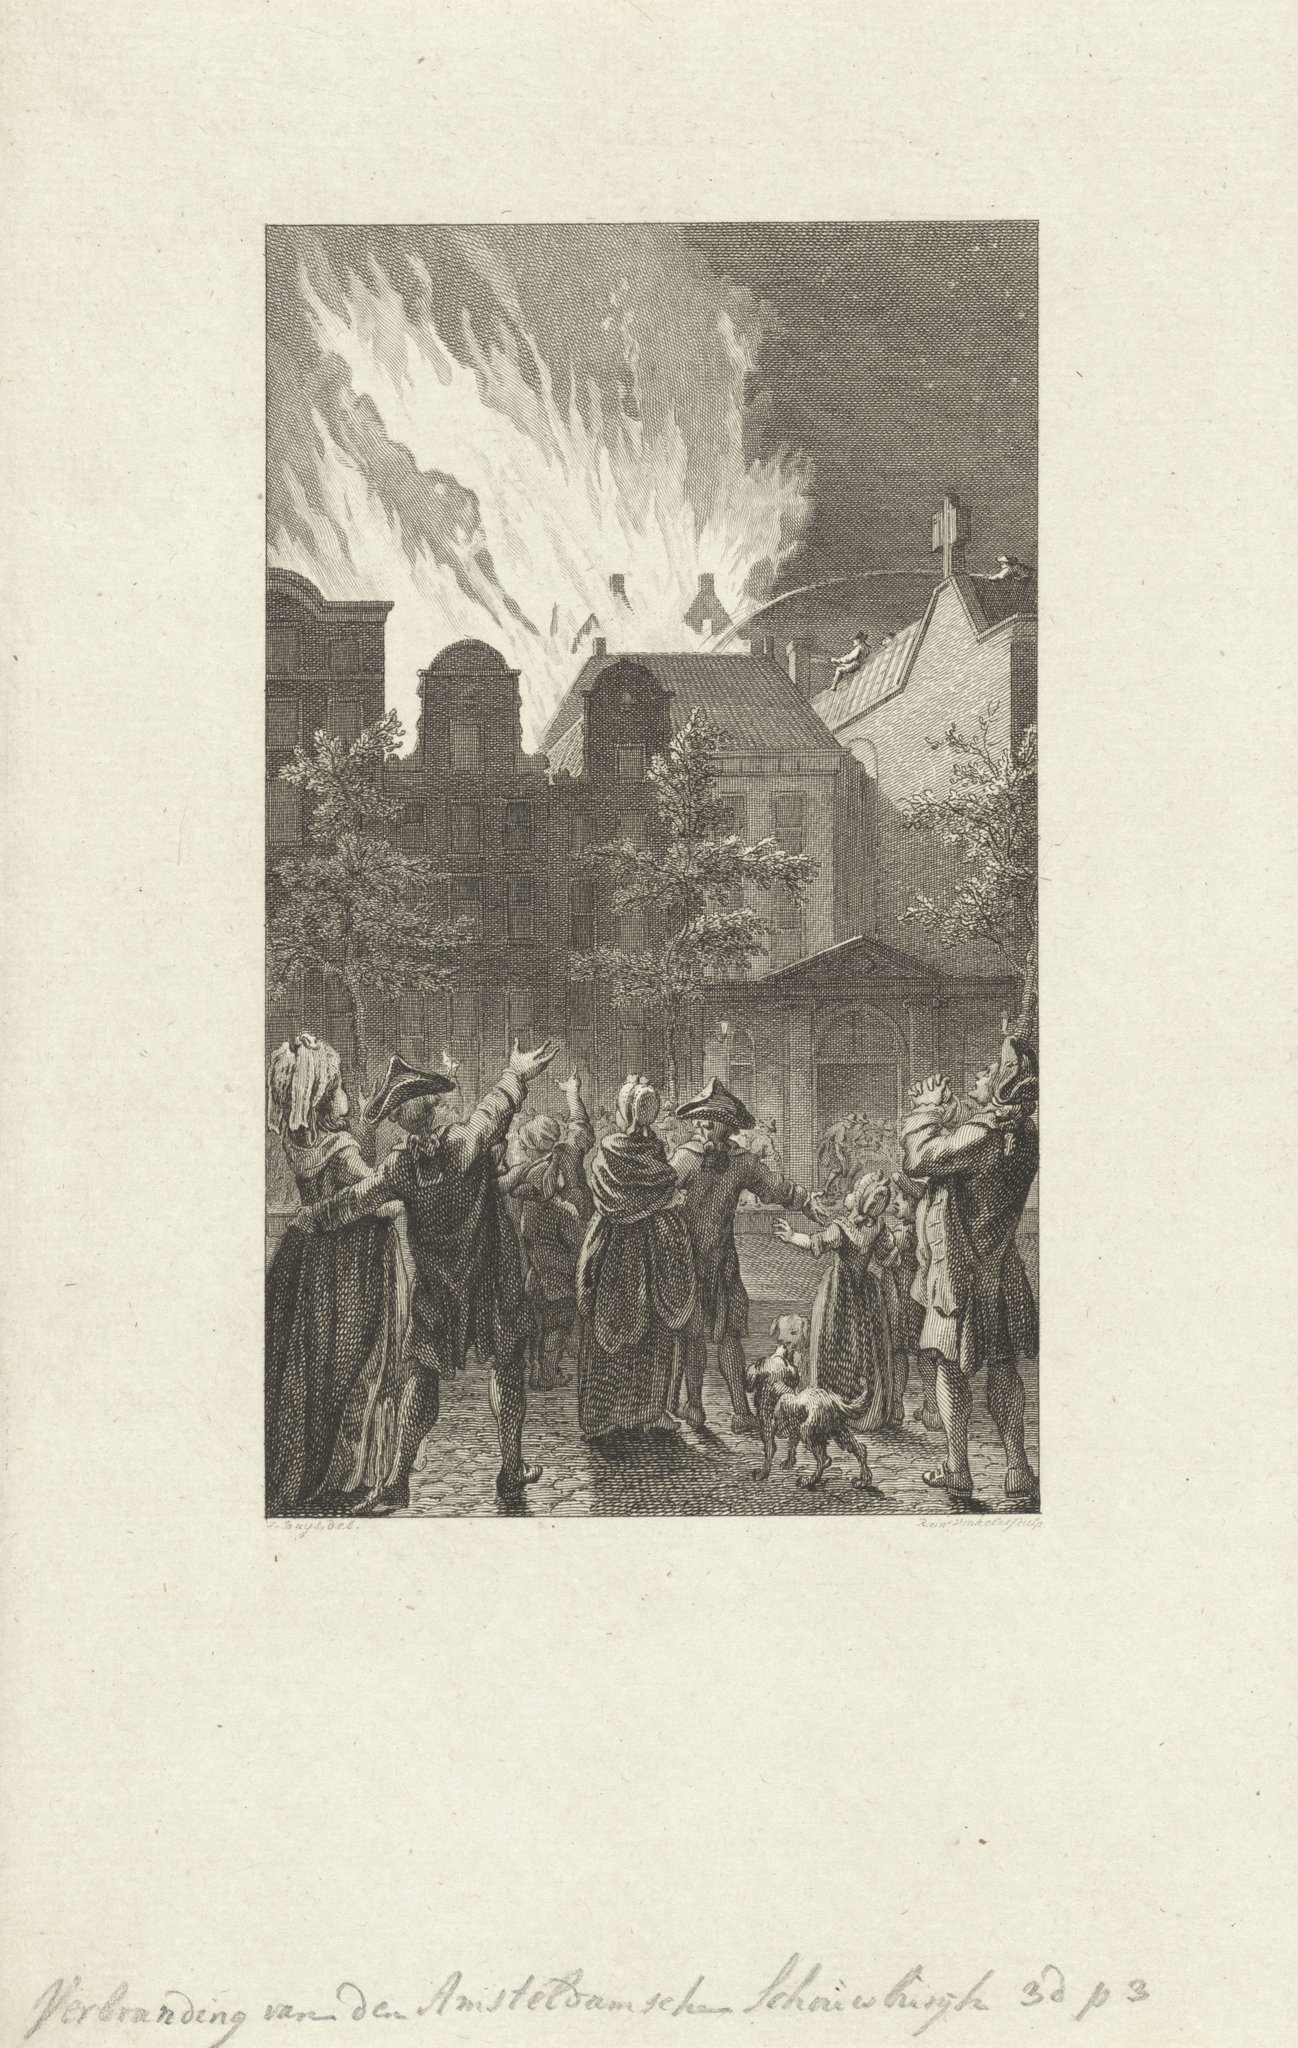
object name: print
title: Brand van de schouwburg aan de Keizersgracht te Amsterdam, 1772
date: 1786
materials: paper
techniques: engraving, etching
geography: amsterdam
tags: on fire, ablaze, theatre (building), fire-fighting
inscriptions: collector's mark: Lugt 240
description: Gezicht op de laaiende brand in de Amsterdamse Schouwburg op 11 mei 1772, gezien vanaf de overzijde van de Keizersgracht. Vanaf het dak rechts wordt getracht het vuur te blussen. Op straat vele toeschouwers.